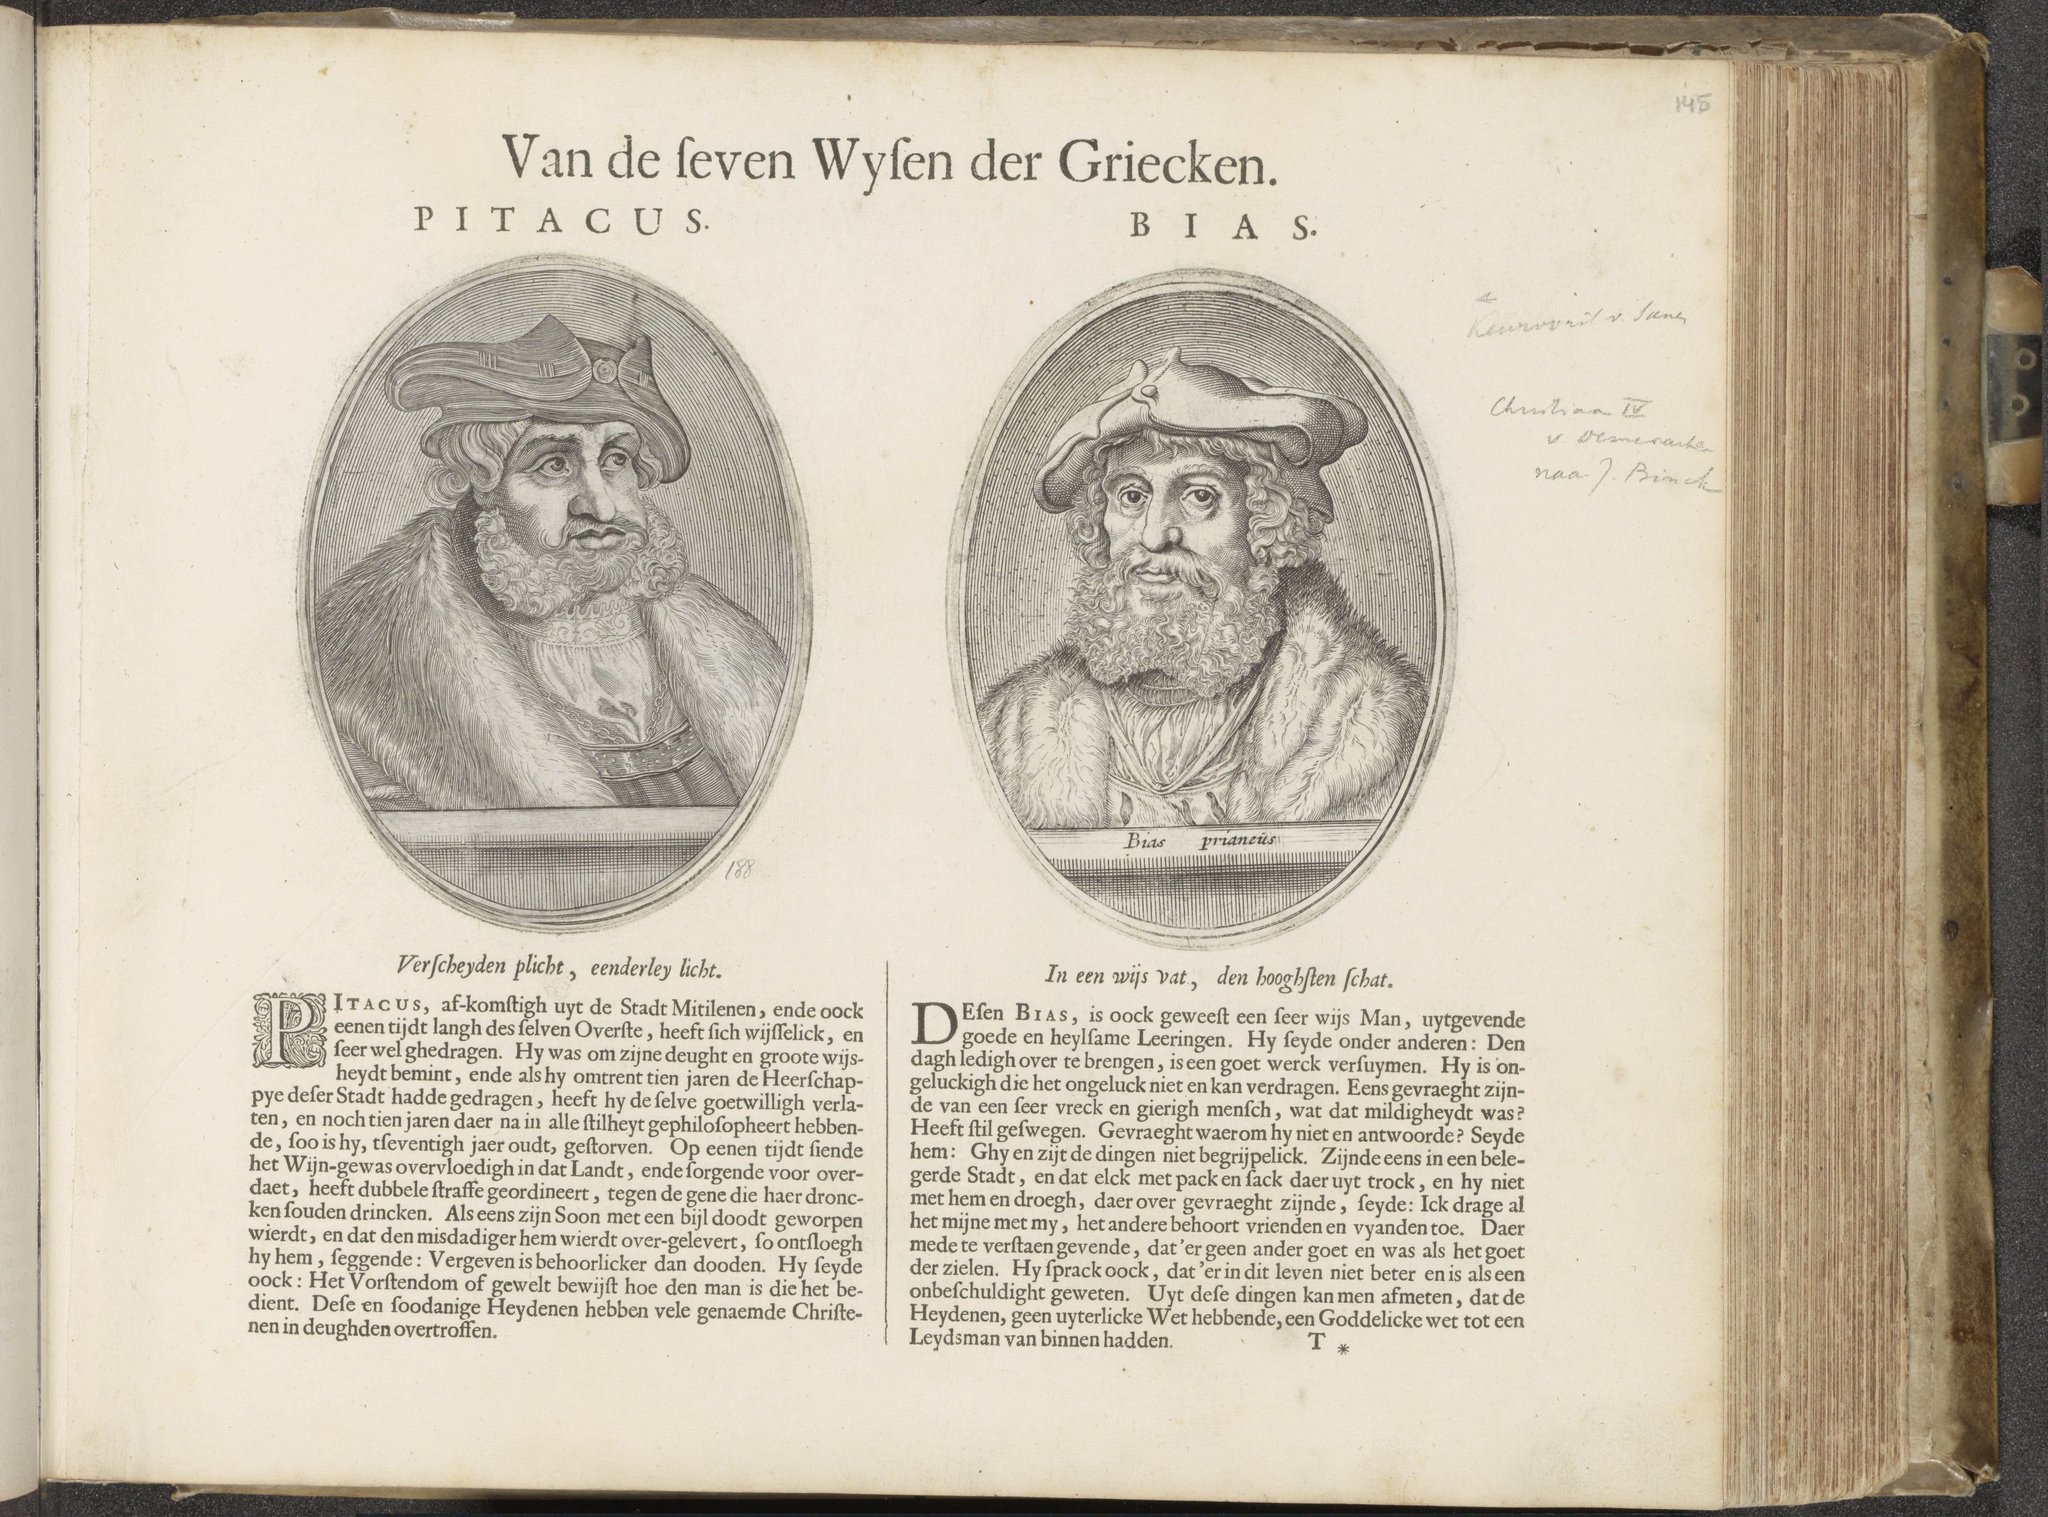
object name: album leaf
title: Portretten van Pittakos van Mytilene en Bias van Priëne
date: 1610-1625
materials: paper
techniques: engraving, letterpress printing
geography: amsterdam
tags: kallundborg, koning, christiaan ii (koning van denemarken, noorwegen en zweden), torgau, lochau, keurvorst, keurvorst van saksen frederik iii de wijze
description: Portretten van keurvorst Frederik III en koning Christiaan II, in dit album gebruikt als afbeeldingen van respectievelijk Pittakos van Mytilene en Bias van Priëne, twee van de zeven wijzen van Griekenland. De begeleidende tekst begint met een kleine gedecoreerde initiaal P. Het blad maakt deel uit van een album.